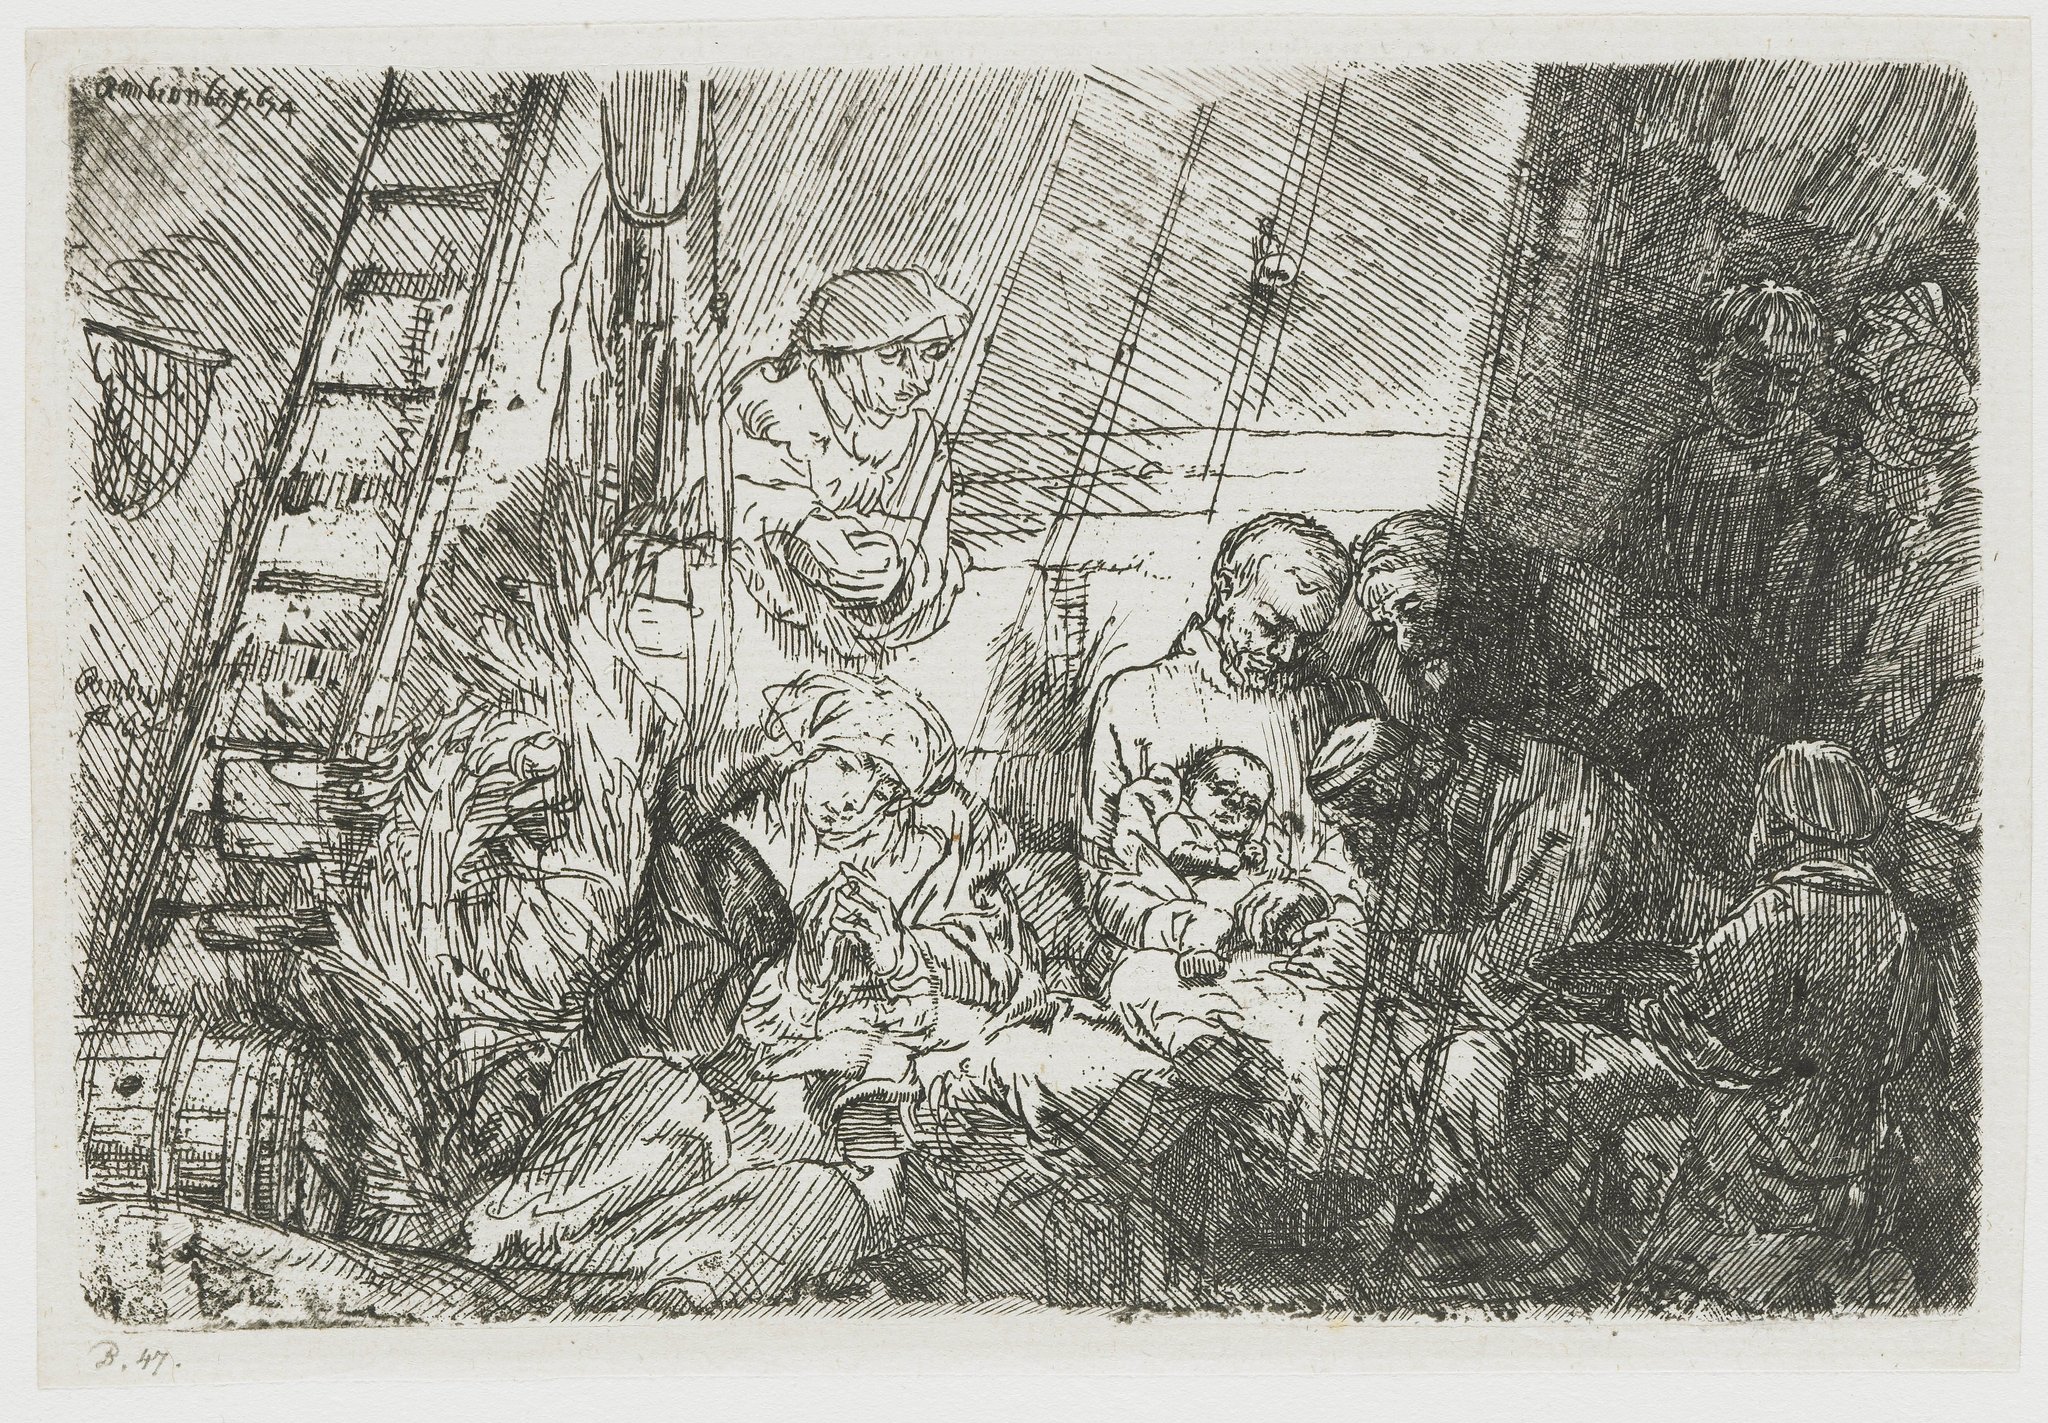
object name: print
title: The circumcision in the stable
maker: rembrandt van rijn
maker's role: draughtsman, painter, print maker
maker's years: 1606-1669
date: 1654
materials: paper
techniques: etching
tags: circumcision of the christ-child by mary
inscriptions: signature and date: ‘Rembrandt f. 1654’, collector's mark: Lugt 2165